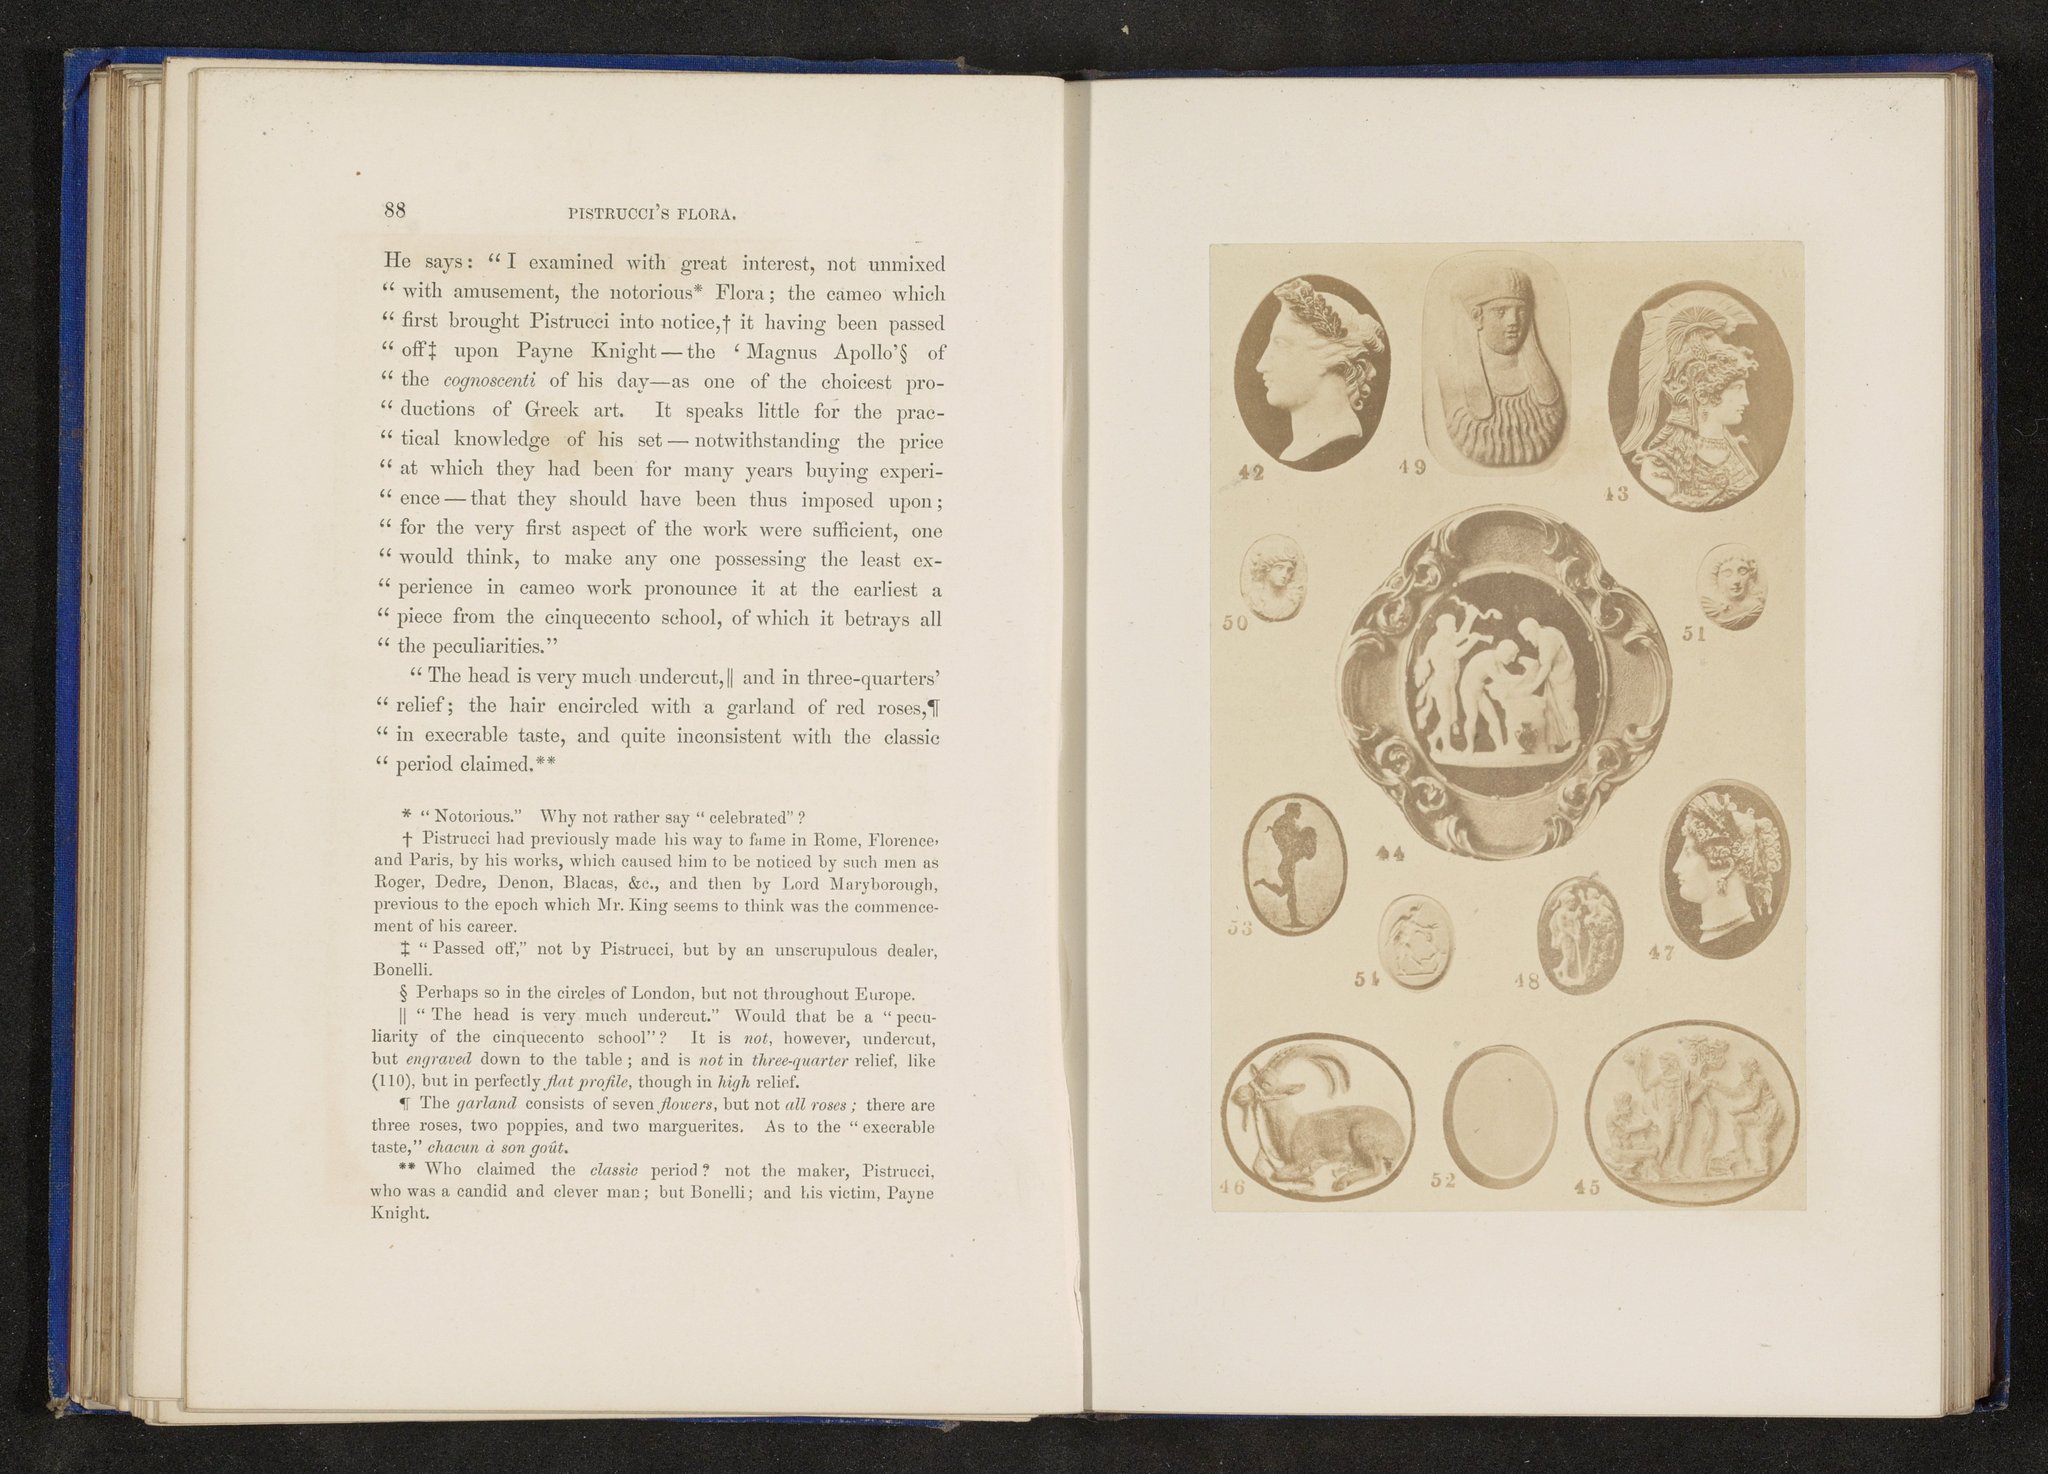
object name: page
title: Dertien cameeën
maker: f. cole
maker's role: fotograaf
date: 1857-1867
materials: photographic support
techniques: albumen print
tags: carving ~ applied arts, historical persons (portraits and scenes from the life) (+ profile portrait), gem, gemstone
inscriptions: number: ‘42 - 54’